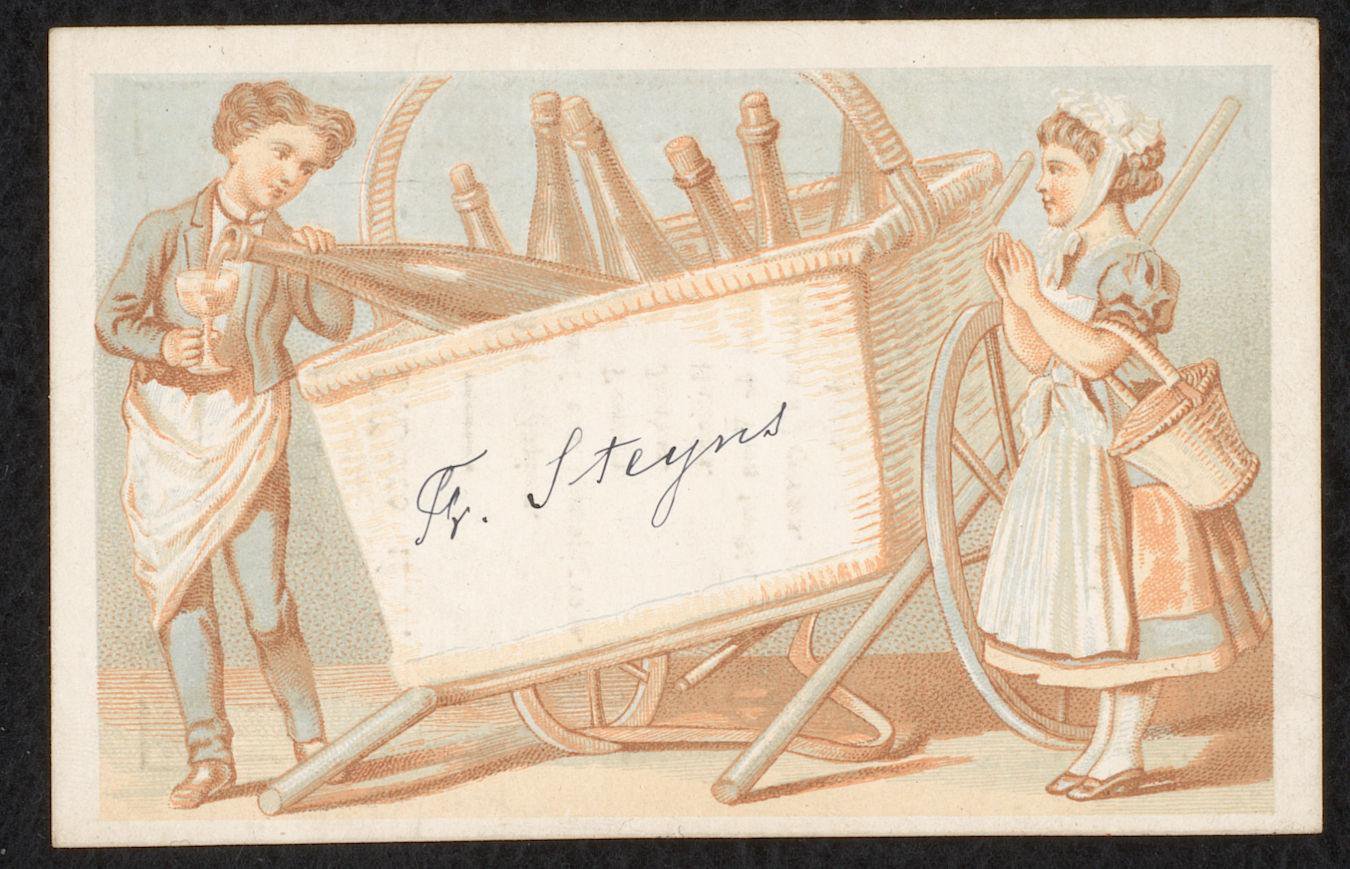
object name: print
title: Menu van een diner op 18 maart 1888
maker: Anonymous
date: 1888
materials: paper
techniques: chromolithography, letterpress printing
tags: flowers: rose, doves, pigeons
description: Op de voorzijde een jongen en een meisje bij een kar met flessen wijn. De jongen schenkt een glas vol uit één van de flessen. Op de achterzijde, in een decoratief kader, de tekst van het menu.